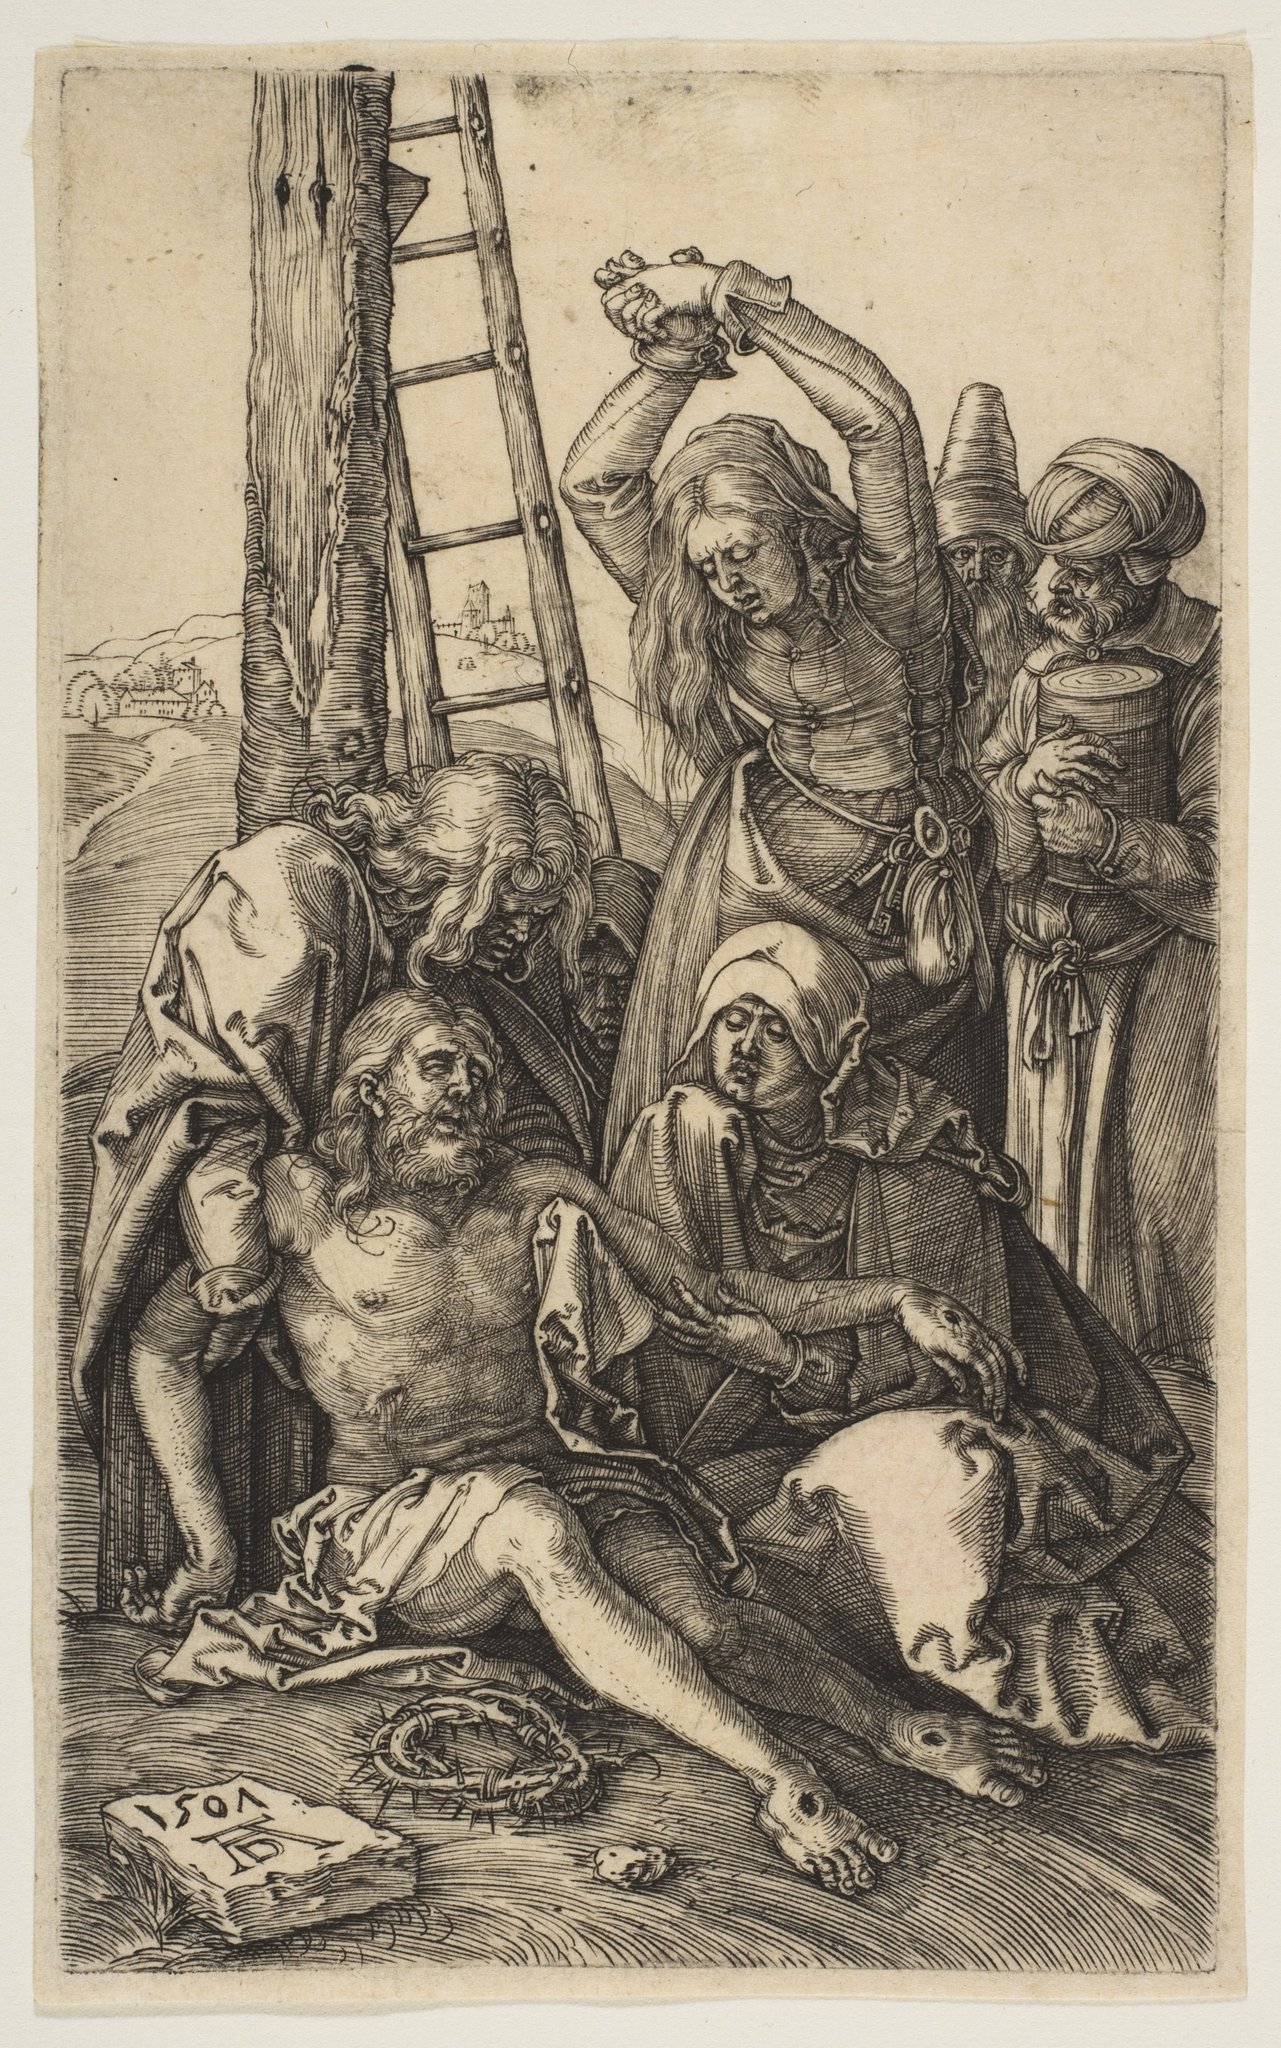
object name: print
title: The Lamentation, from "The Passion"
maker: albrecht dürer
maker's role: artist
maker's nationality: german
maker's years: 1471-1528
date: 1507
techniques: engraving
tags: men,women,lamentation,ladders